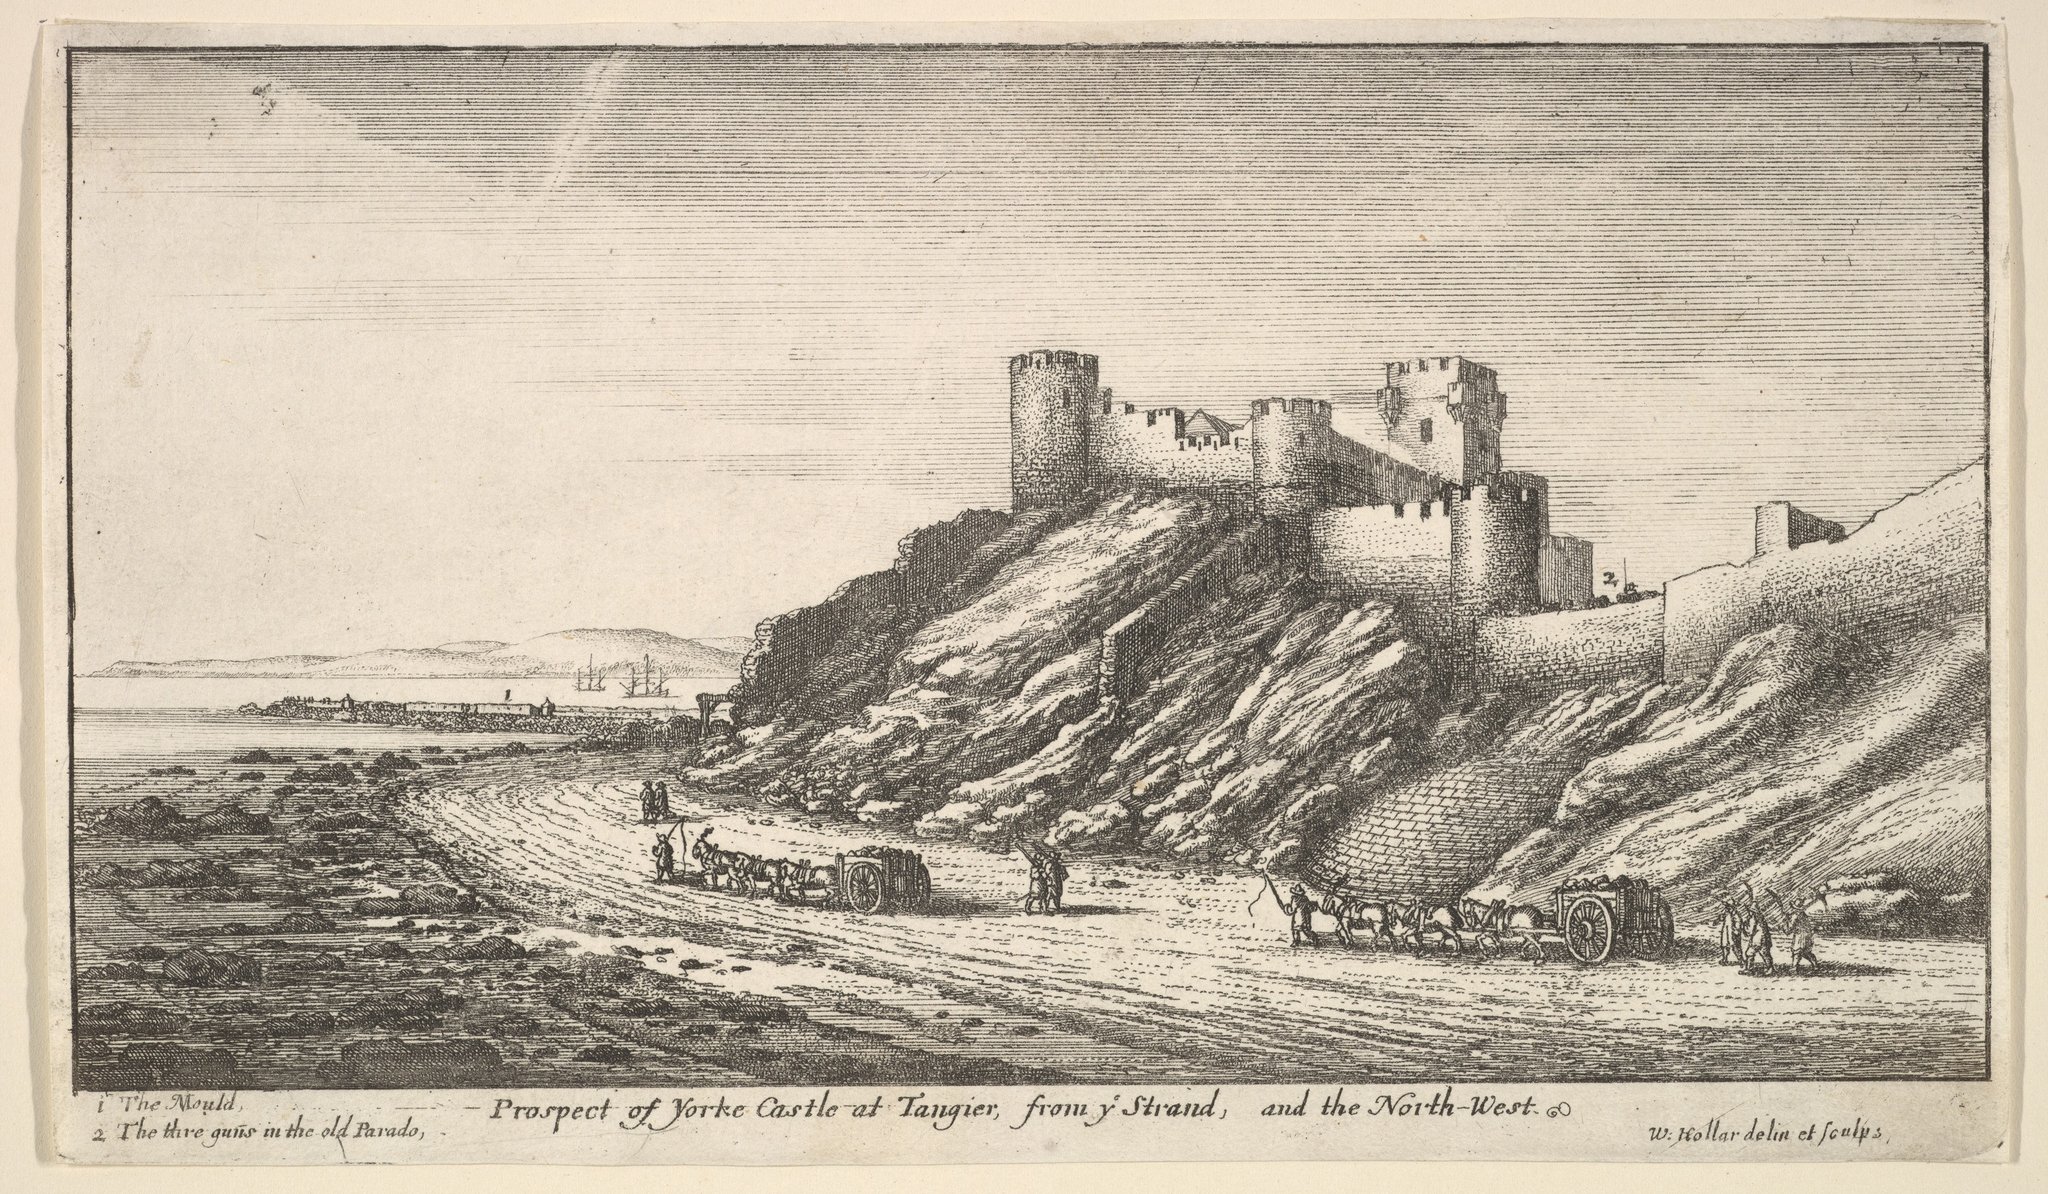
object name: print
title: Prospect of Yorke Castle at Tangier, from ye Strand, and the North-West, from "Views of Tangier"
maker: wenceslaus hollar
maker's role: artist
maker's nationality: bohemian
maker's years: 1607-1677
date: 1669-1673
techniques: etching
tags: castles,horses,carts